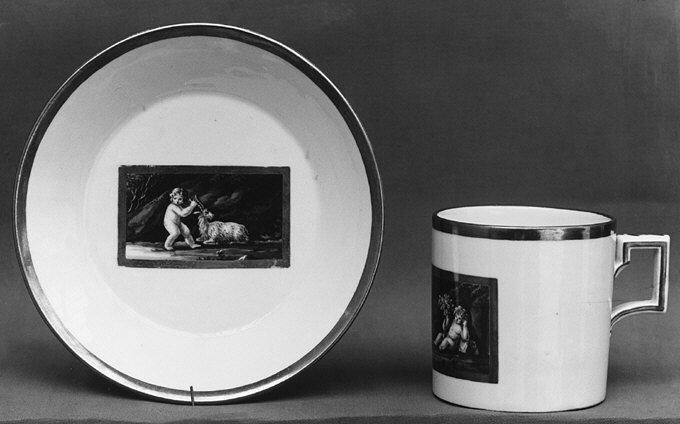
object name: cup and saucer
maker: fürstenberg porcelain manufactory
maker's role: manufactory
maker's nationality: german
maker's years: 1747-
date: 1750-1795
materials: hard paste porcelain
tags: children,goats